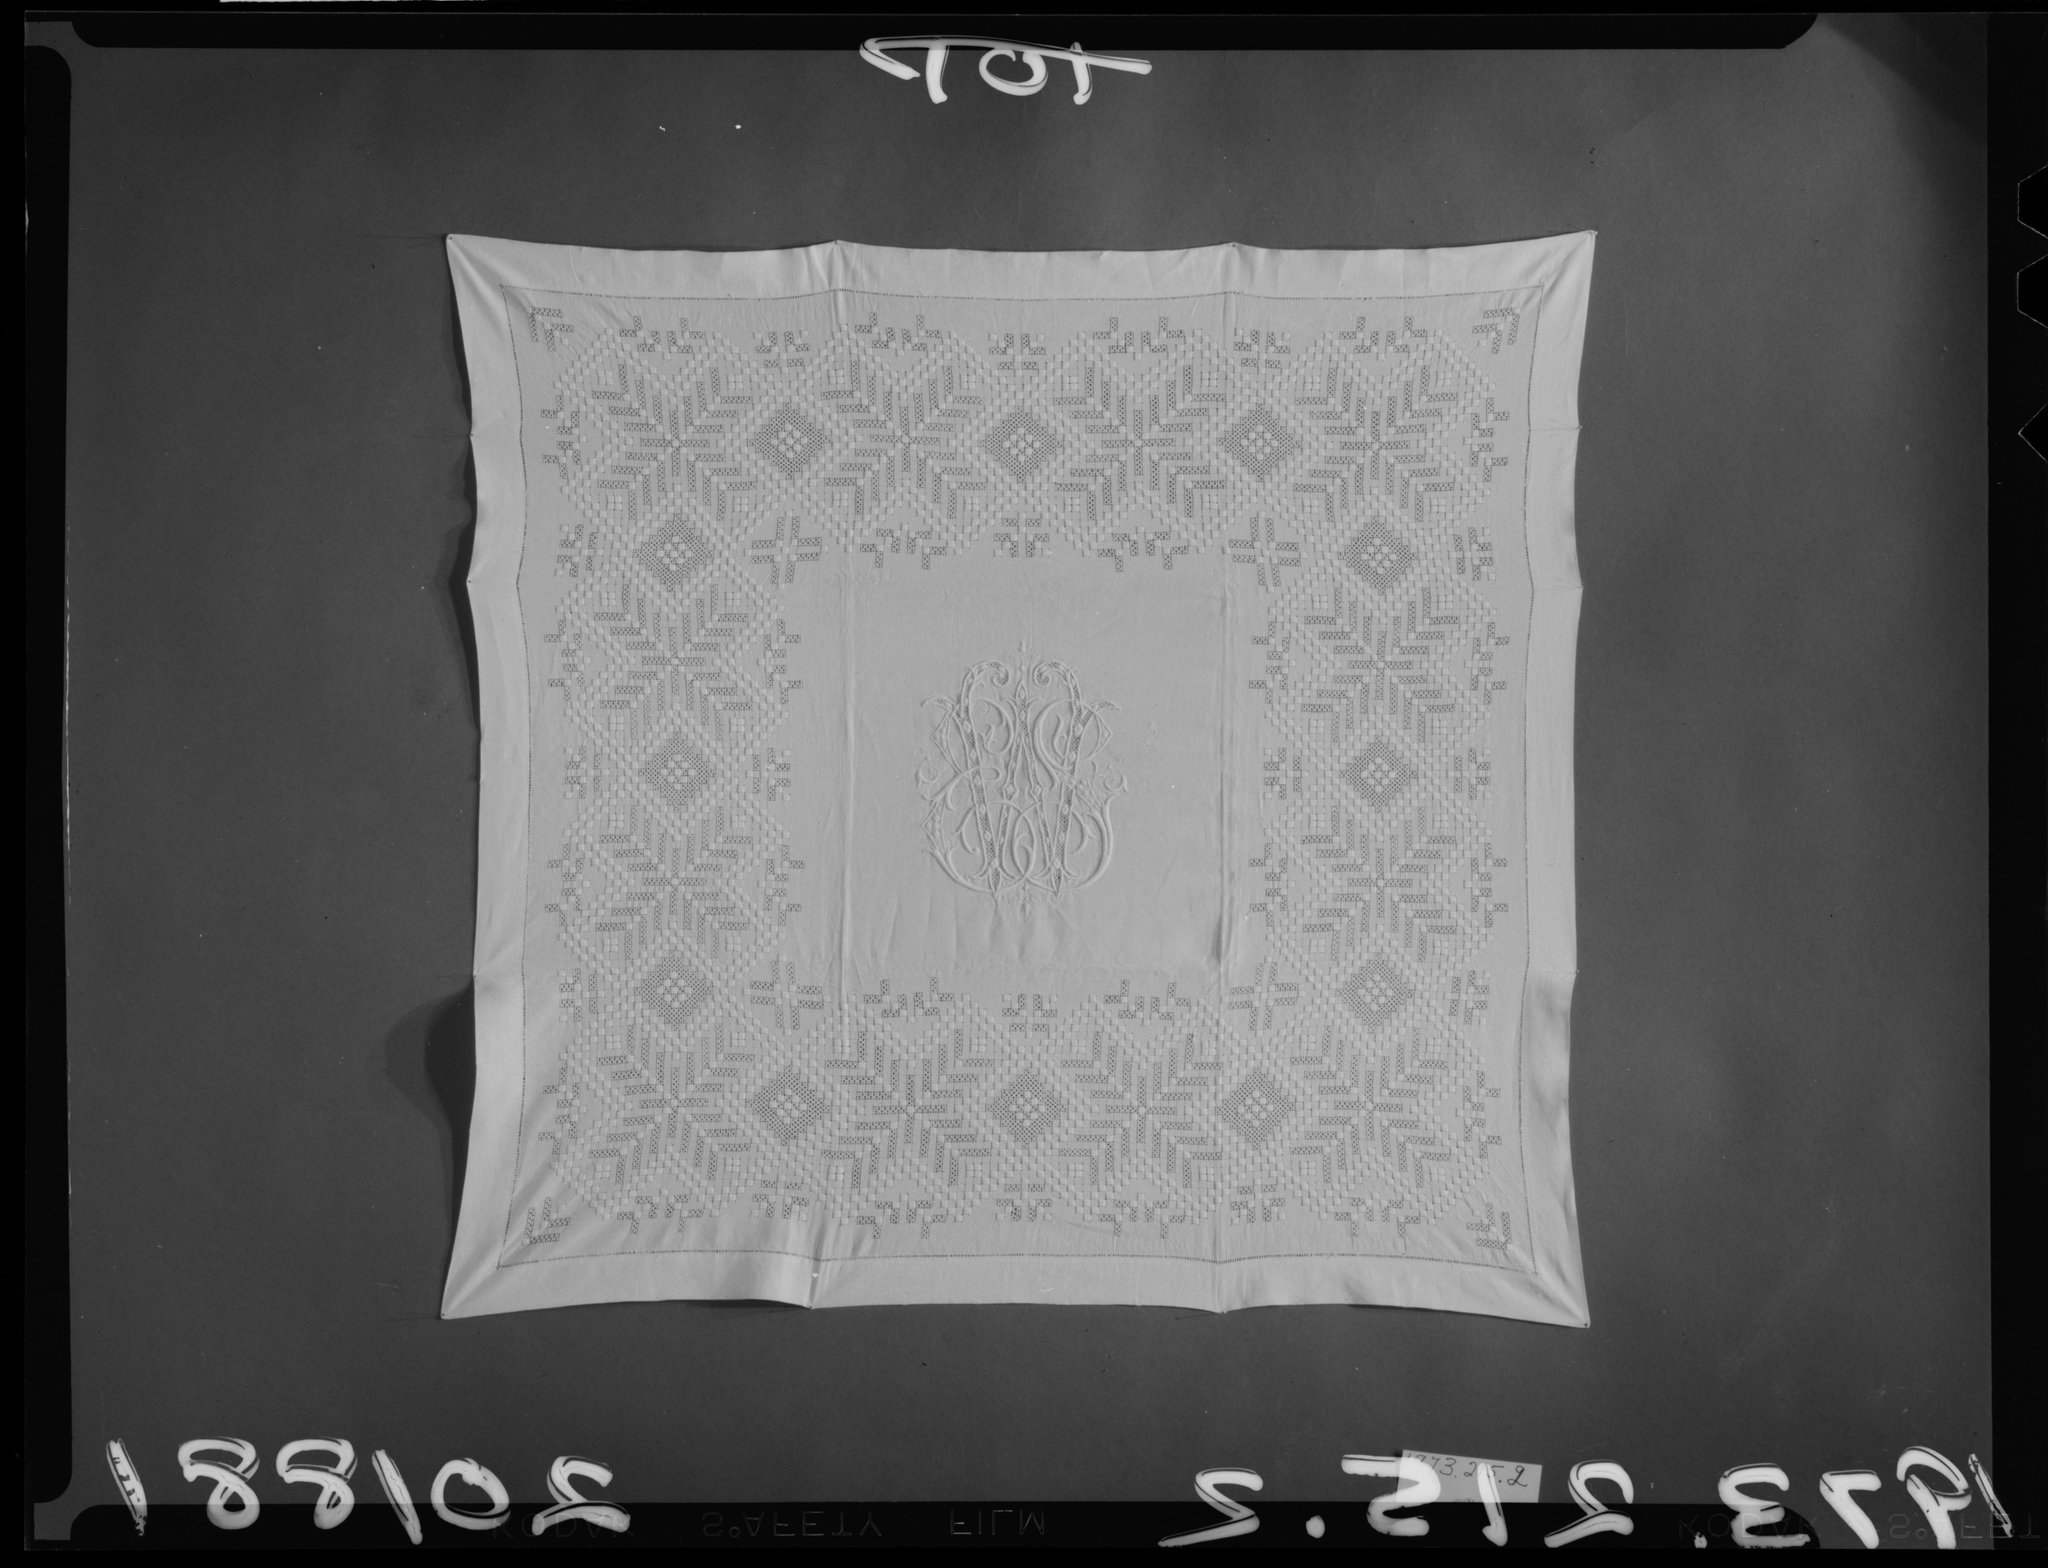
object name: pillow sham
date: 1890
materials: linen